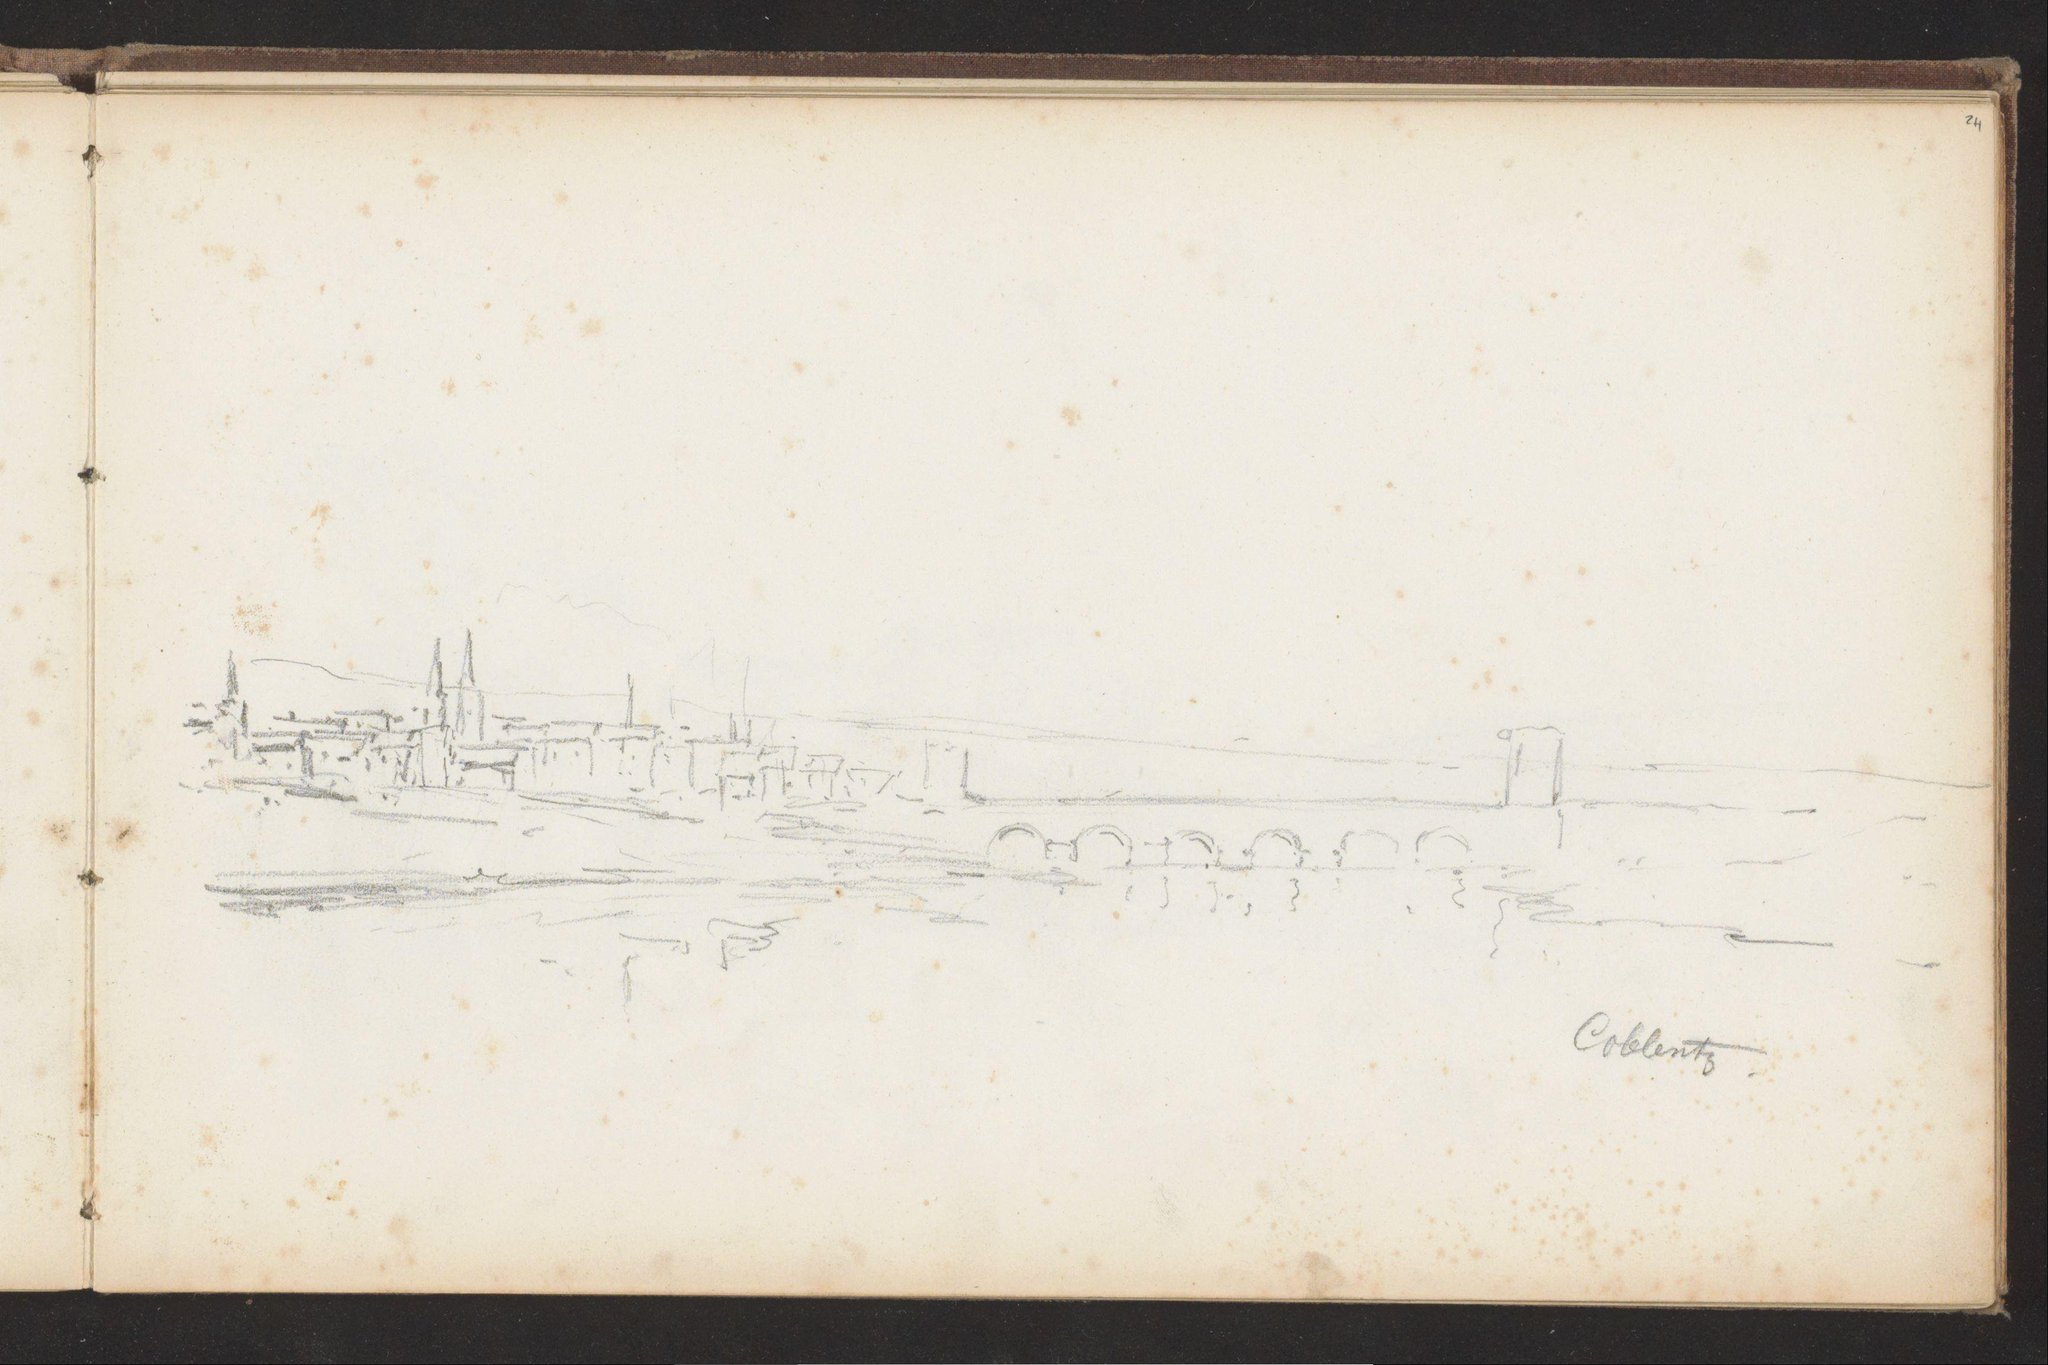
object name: sketchbook leaf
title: Gezicht op Koblenz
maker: maria vos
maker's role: draughtsman, painter, print maker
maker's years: 1824-1906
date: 1860-1865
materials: paper, pencil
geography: koblenz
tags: city-view, and landscape with man-made constructions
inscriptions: annotation: ‘Coblentz.’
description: Blad 24 recto uit een schetsboek met 55 bladen.